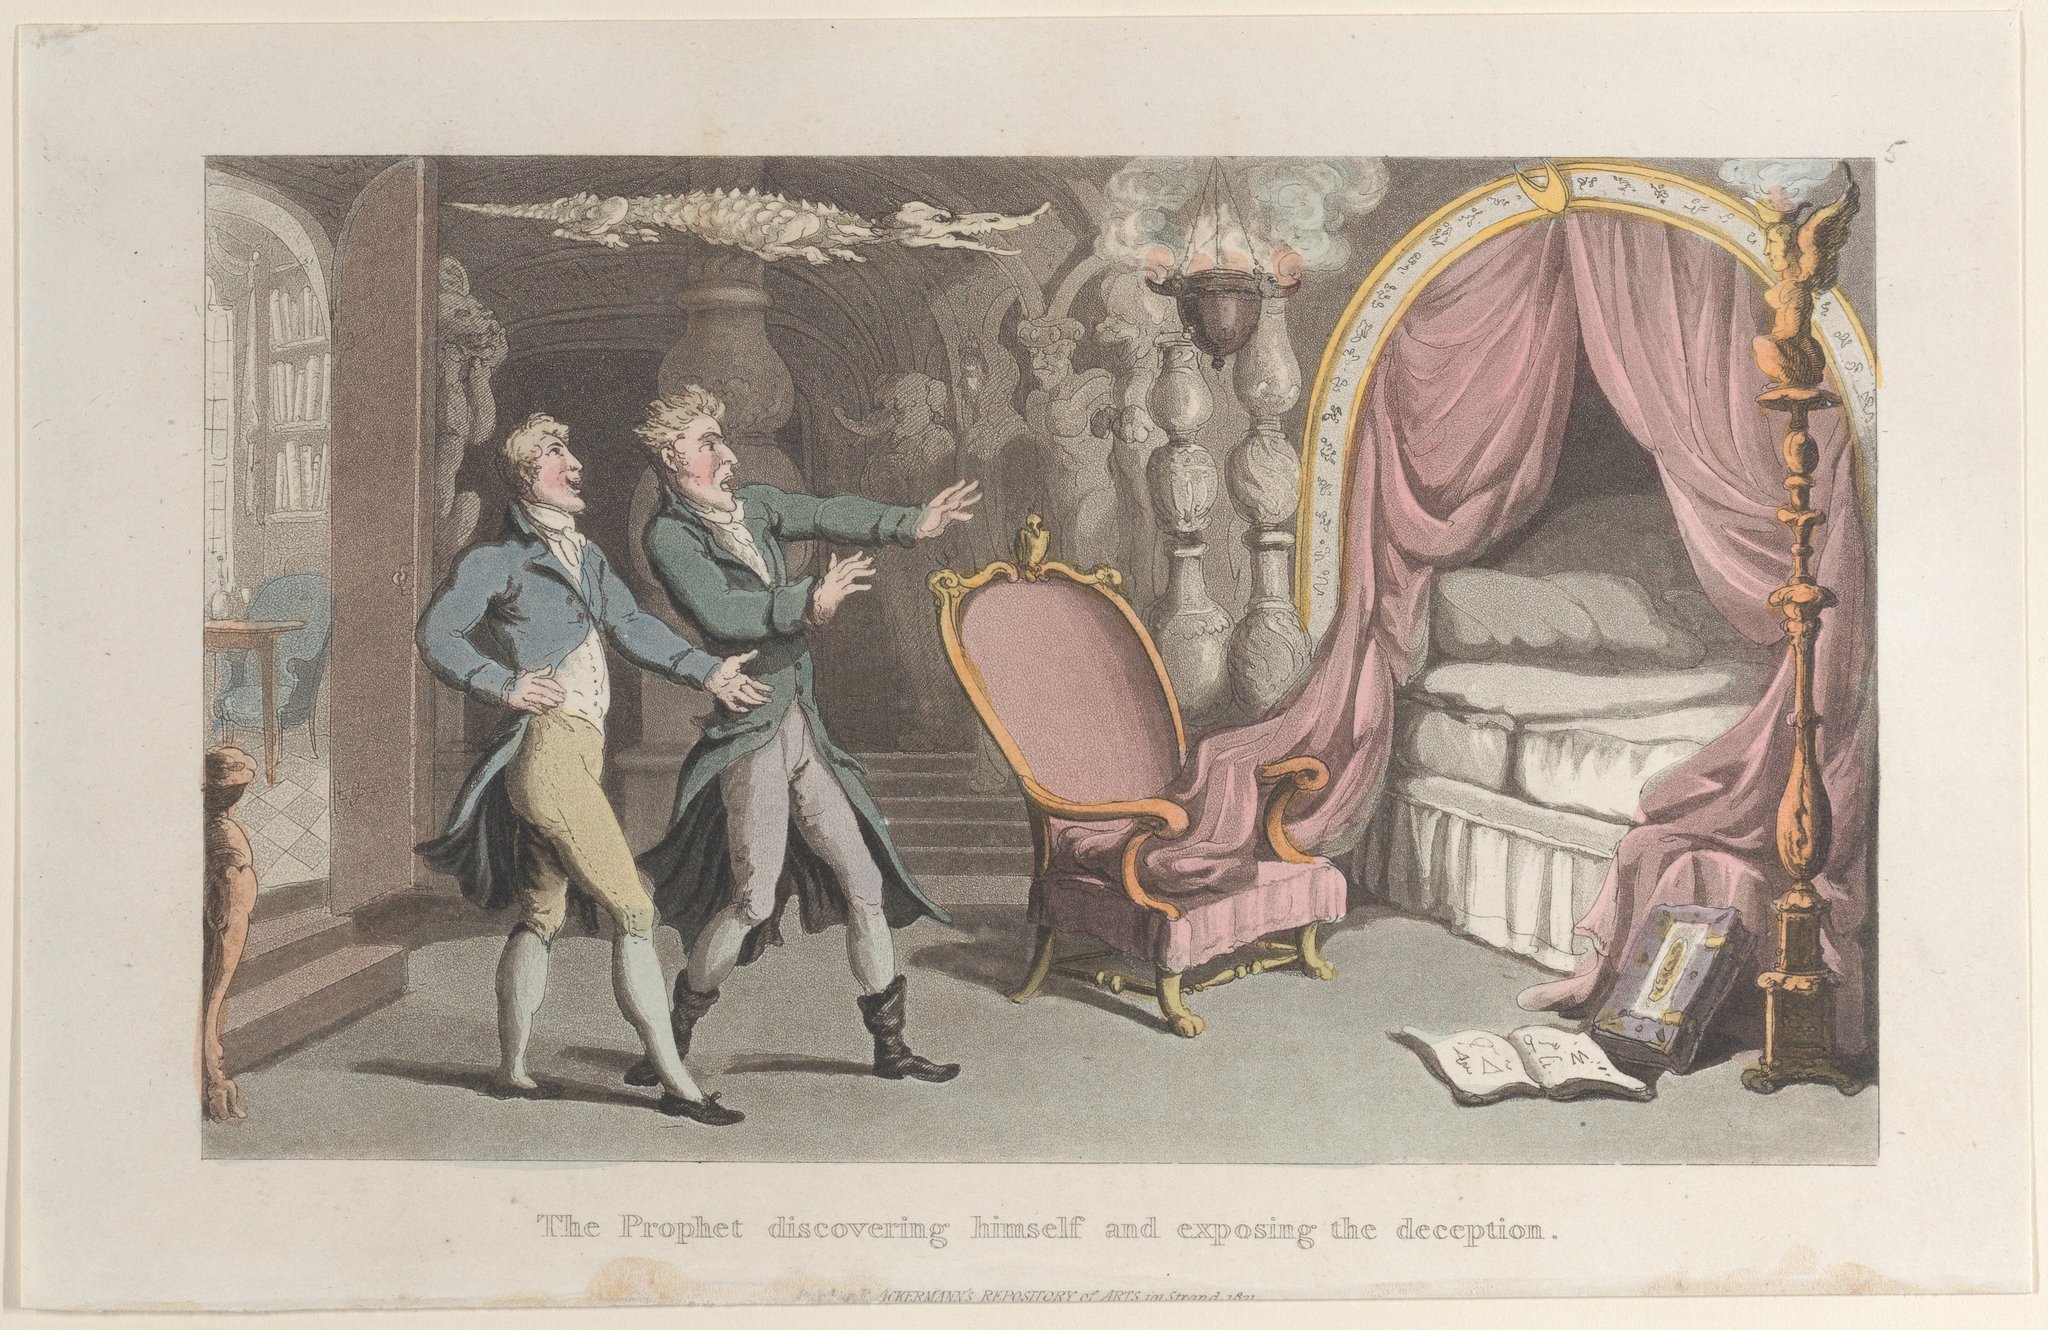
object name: print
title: The Prophet discovering himself and exposing the deception, from "Journal of Sentimental Travels in the Southern Provinces of France, Shortly Before the Revolution"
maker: thomas rowlandson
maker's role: artist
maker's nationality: british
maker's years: 1757-1827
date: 1821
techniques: aquatint, etching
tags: bedrooms,men,crocodiles